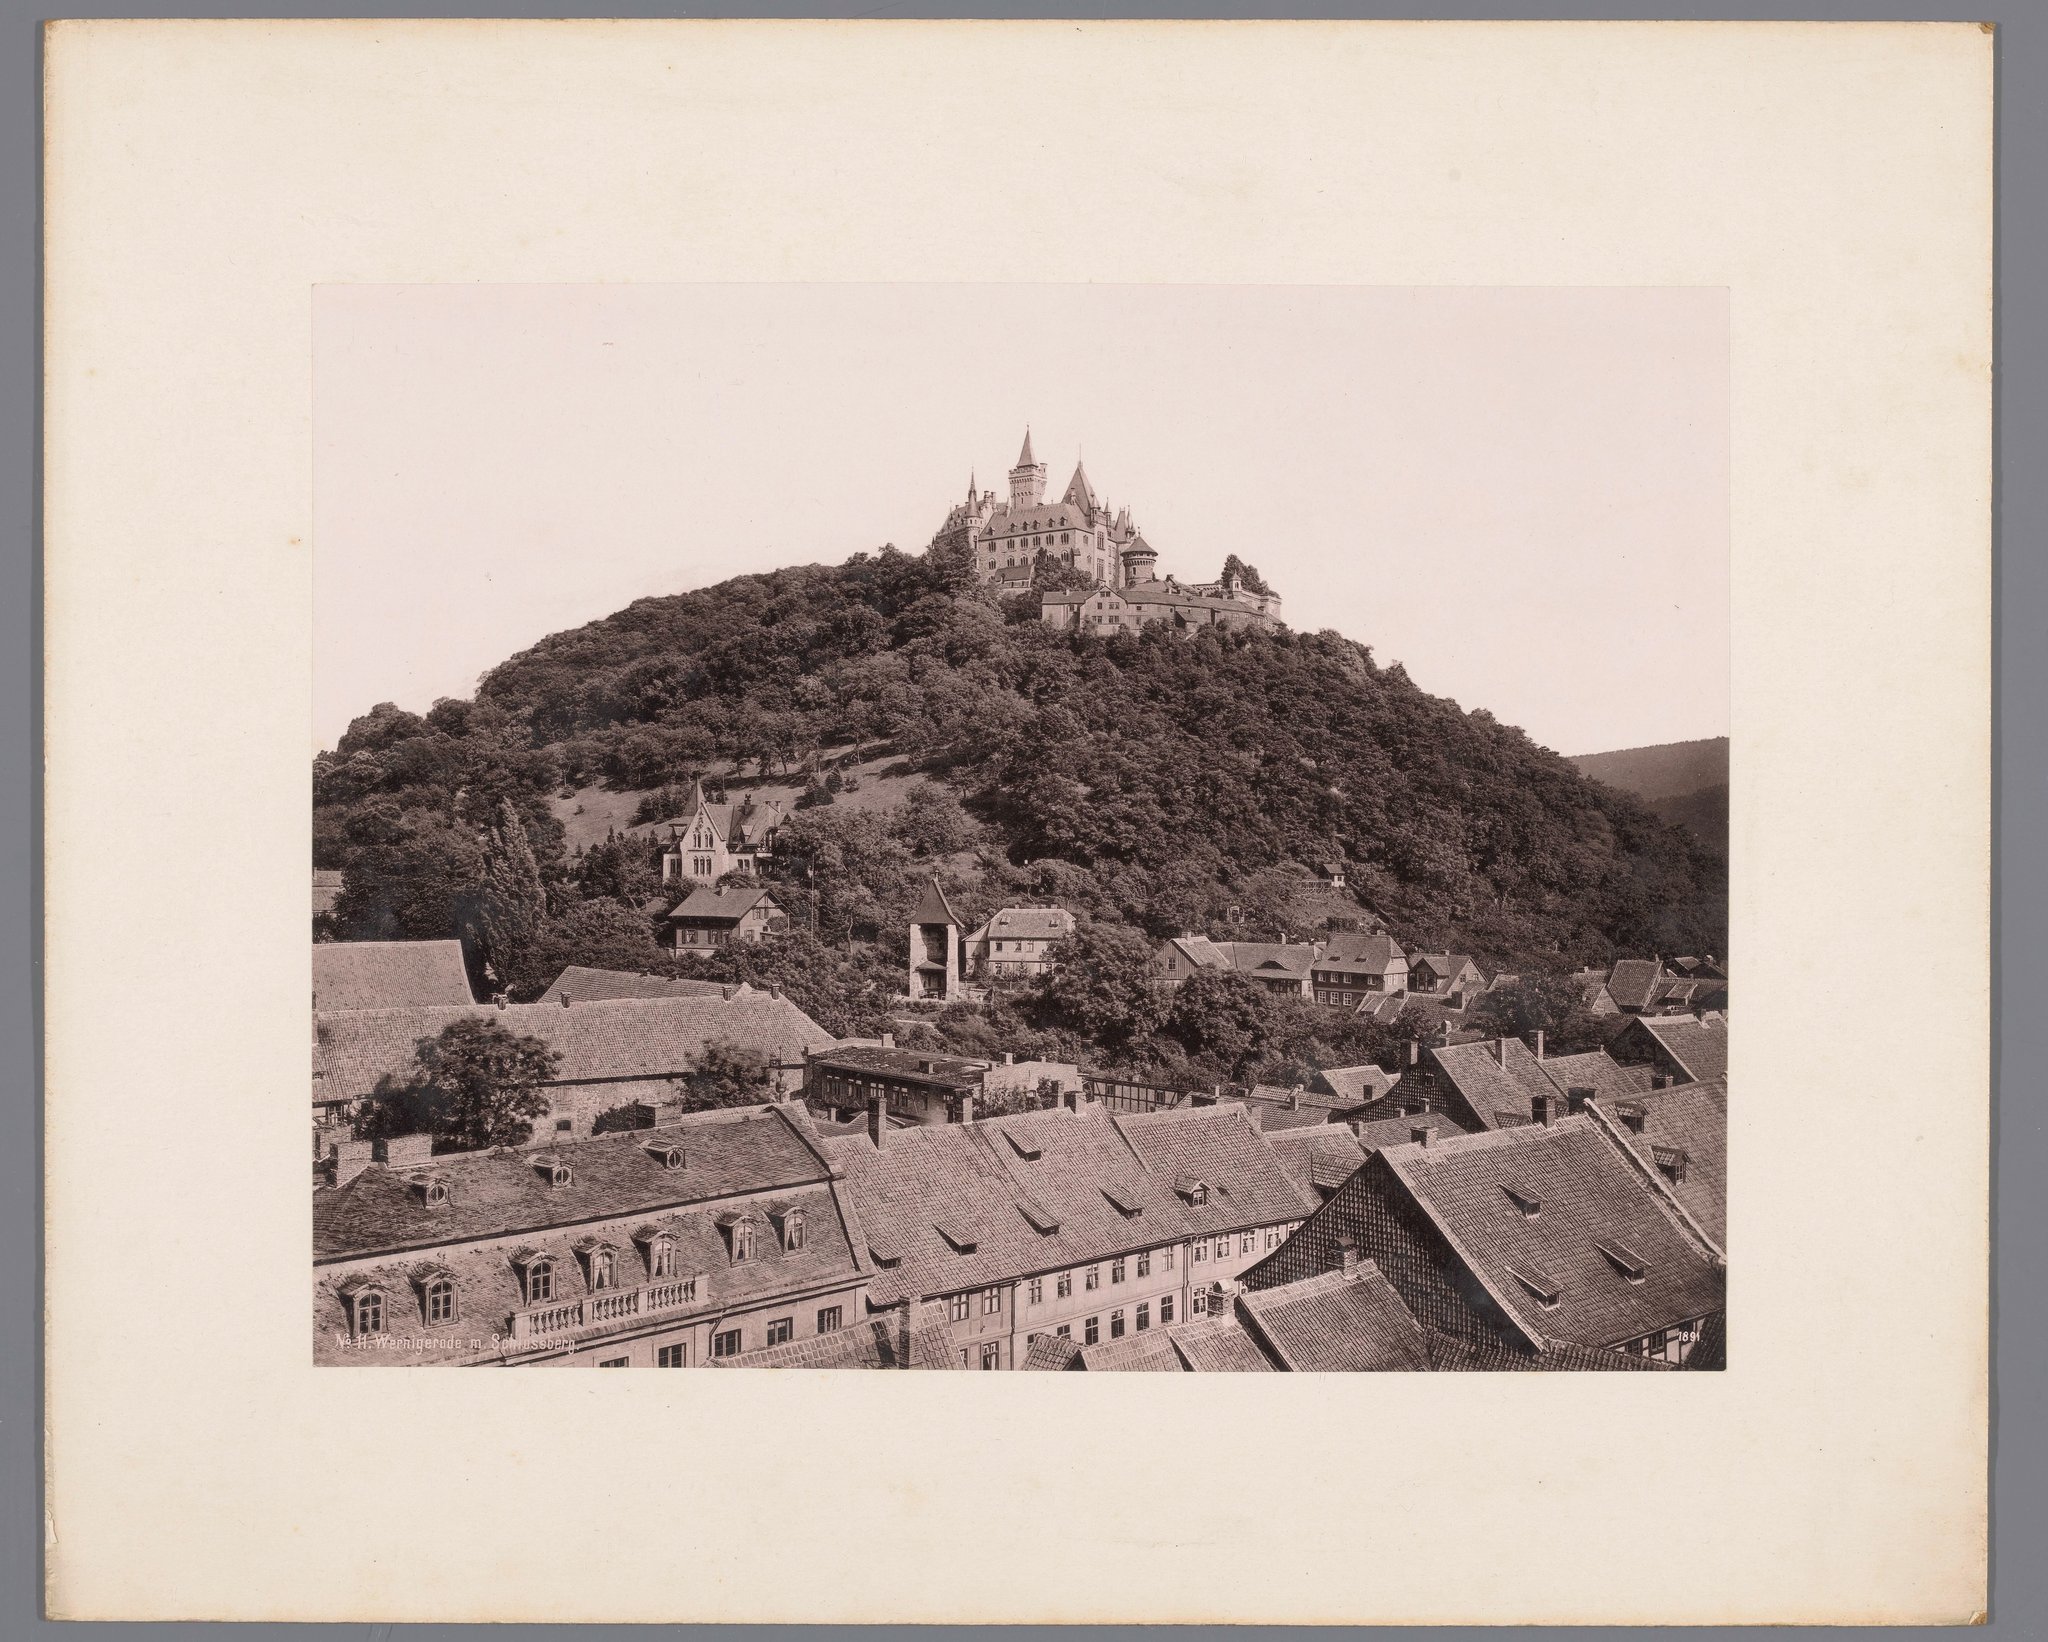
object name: photomechanical print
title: Wernigerode m. Schlossberg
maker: Anonymous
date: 1891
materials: cardboard, paper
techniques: photograph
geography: wernigerode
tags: city-view in general; 'veduta', landscape with tower or castle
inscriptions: inscription: ‘No. 11. Wernigerode m. Schlossberg.’